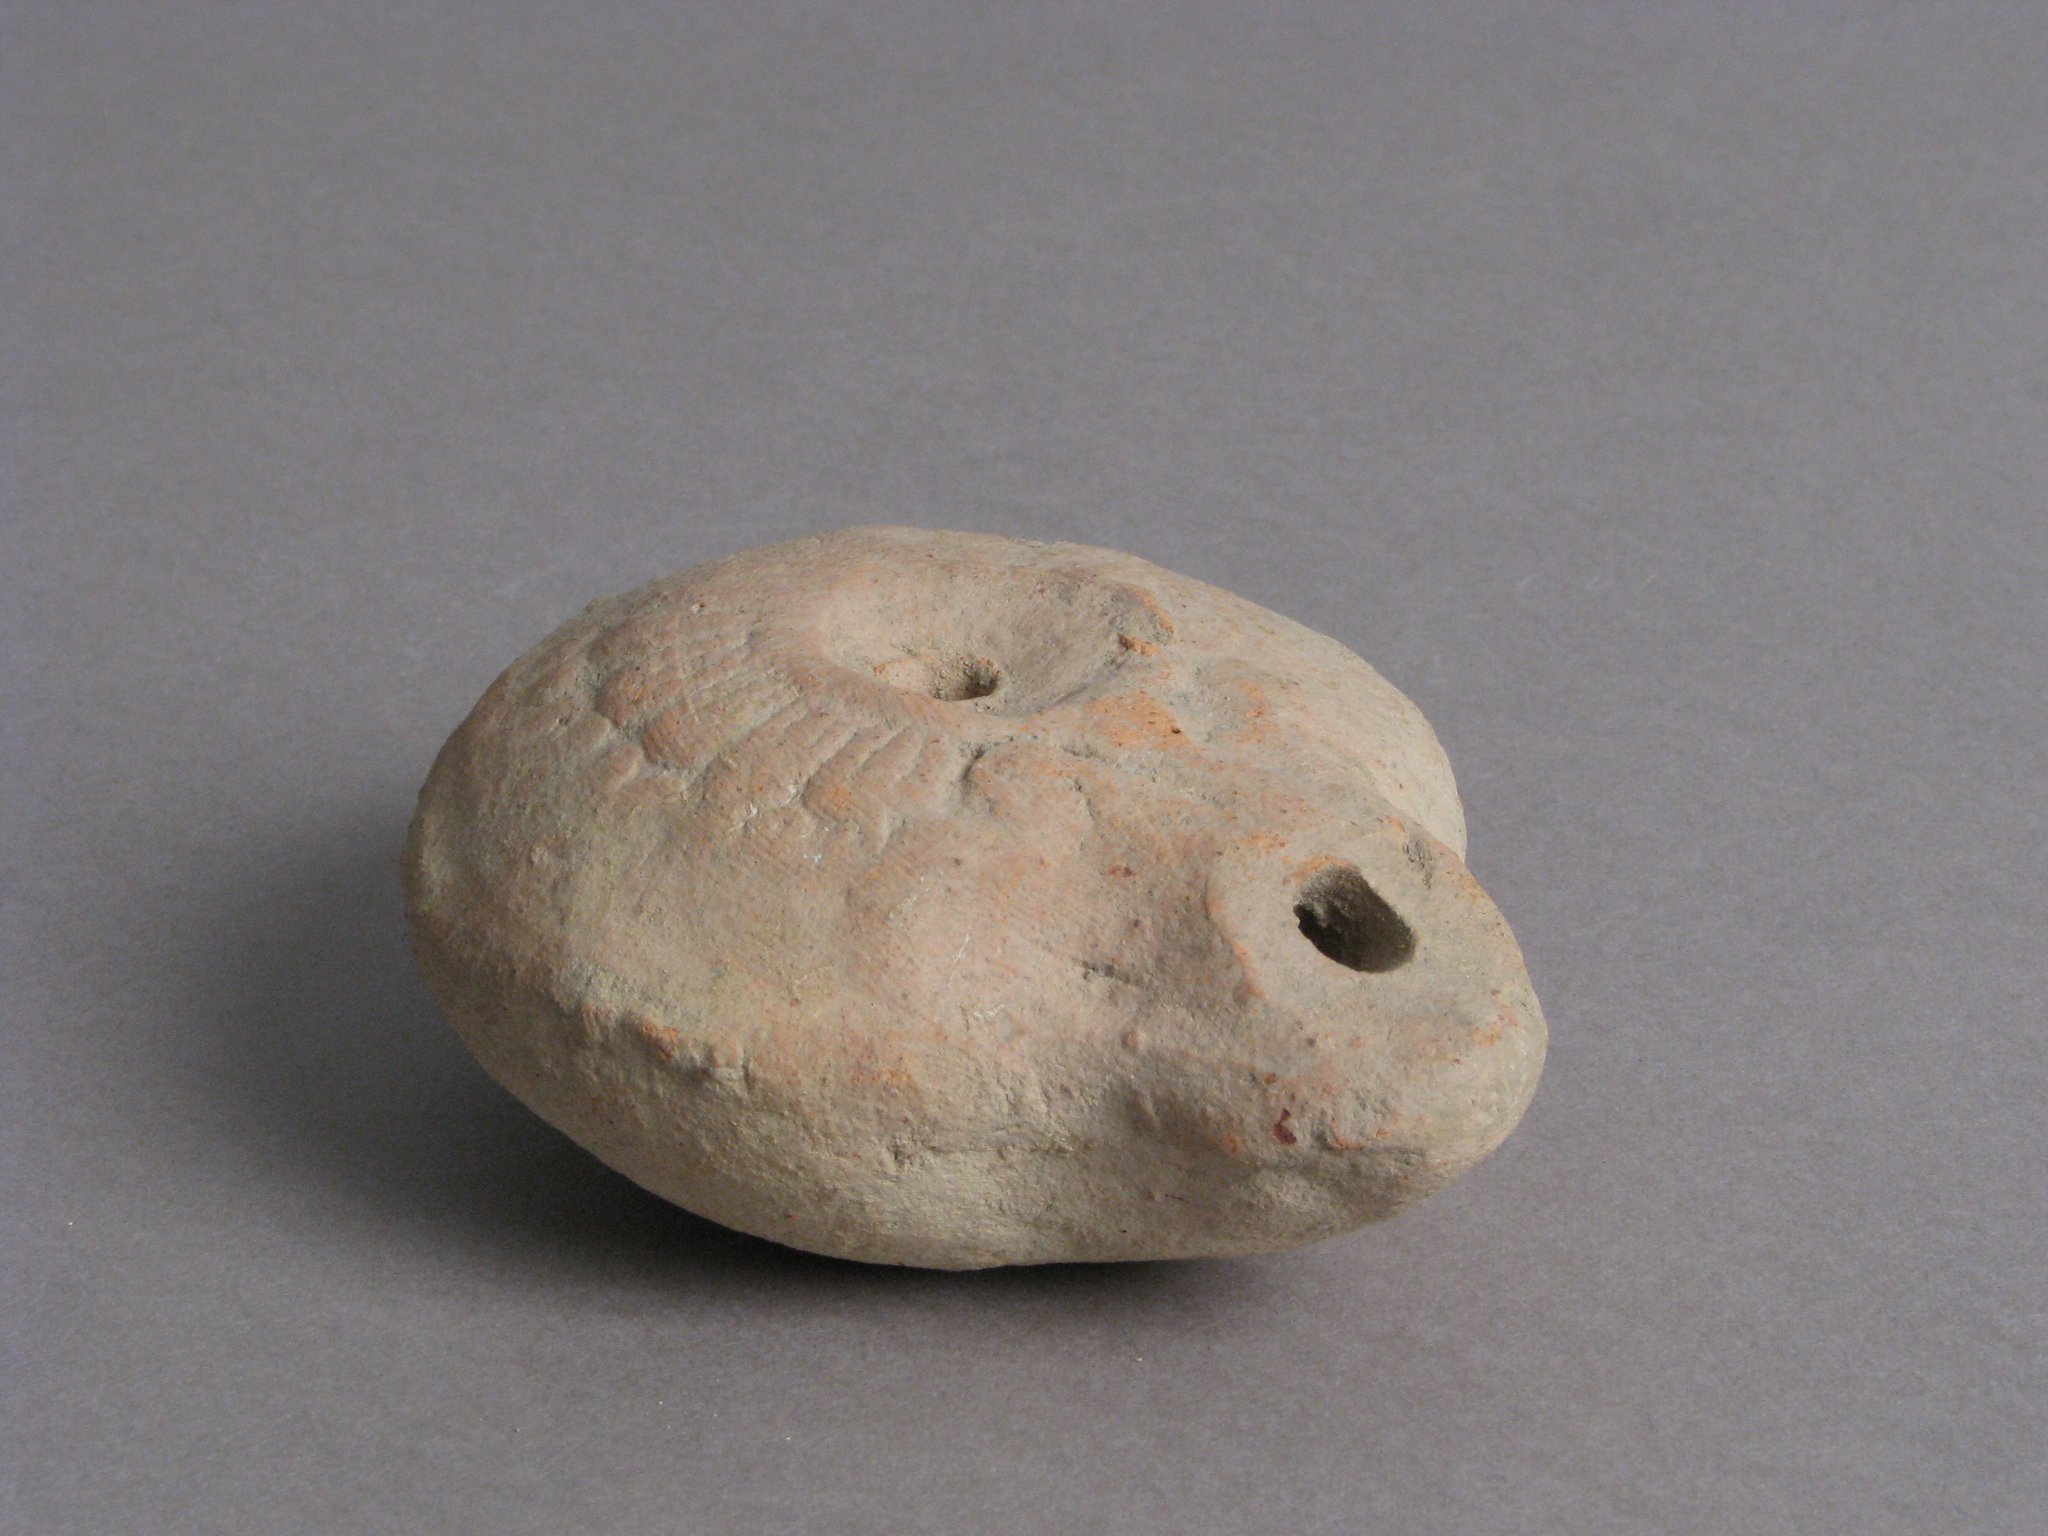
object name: lamp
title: Oil Lamp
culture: coptic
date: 301-700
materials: earthenware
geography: egypt